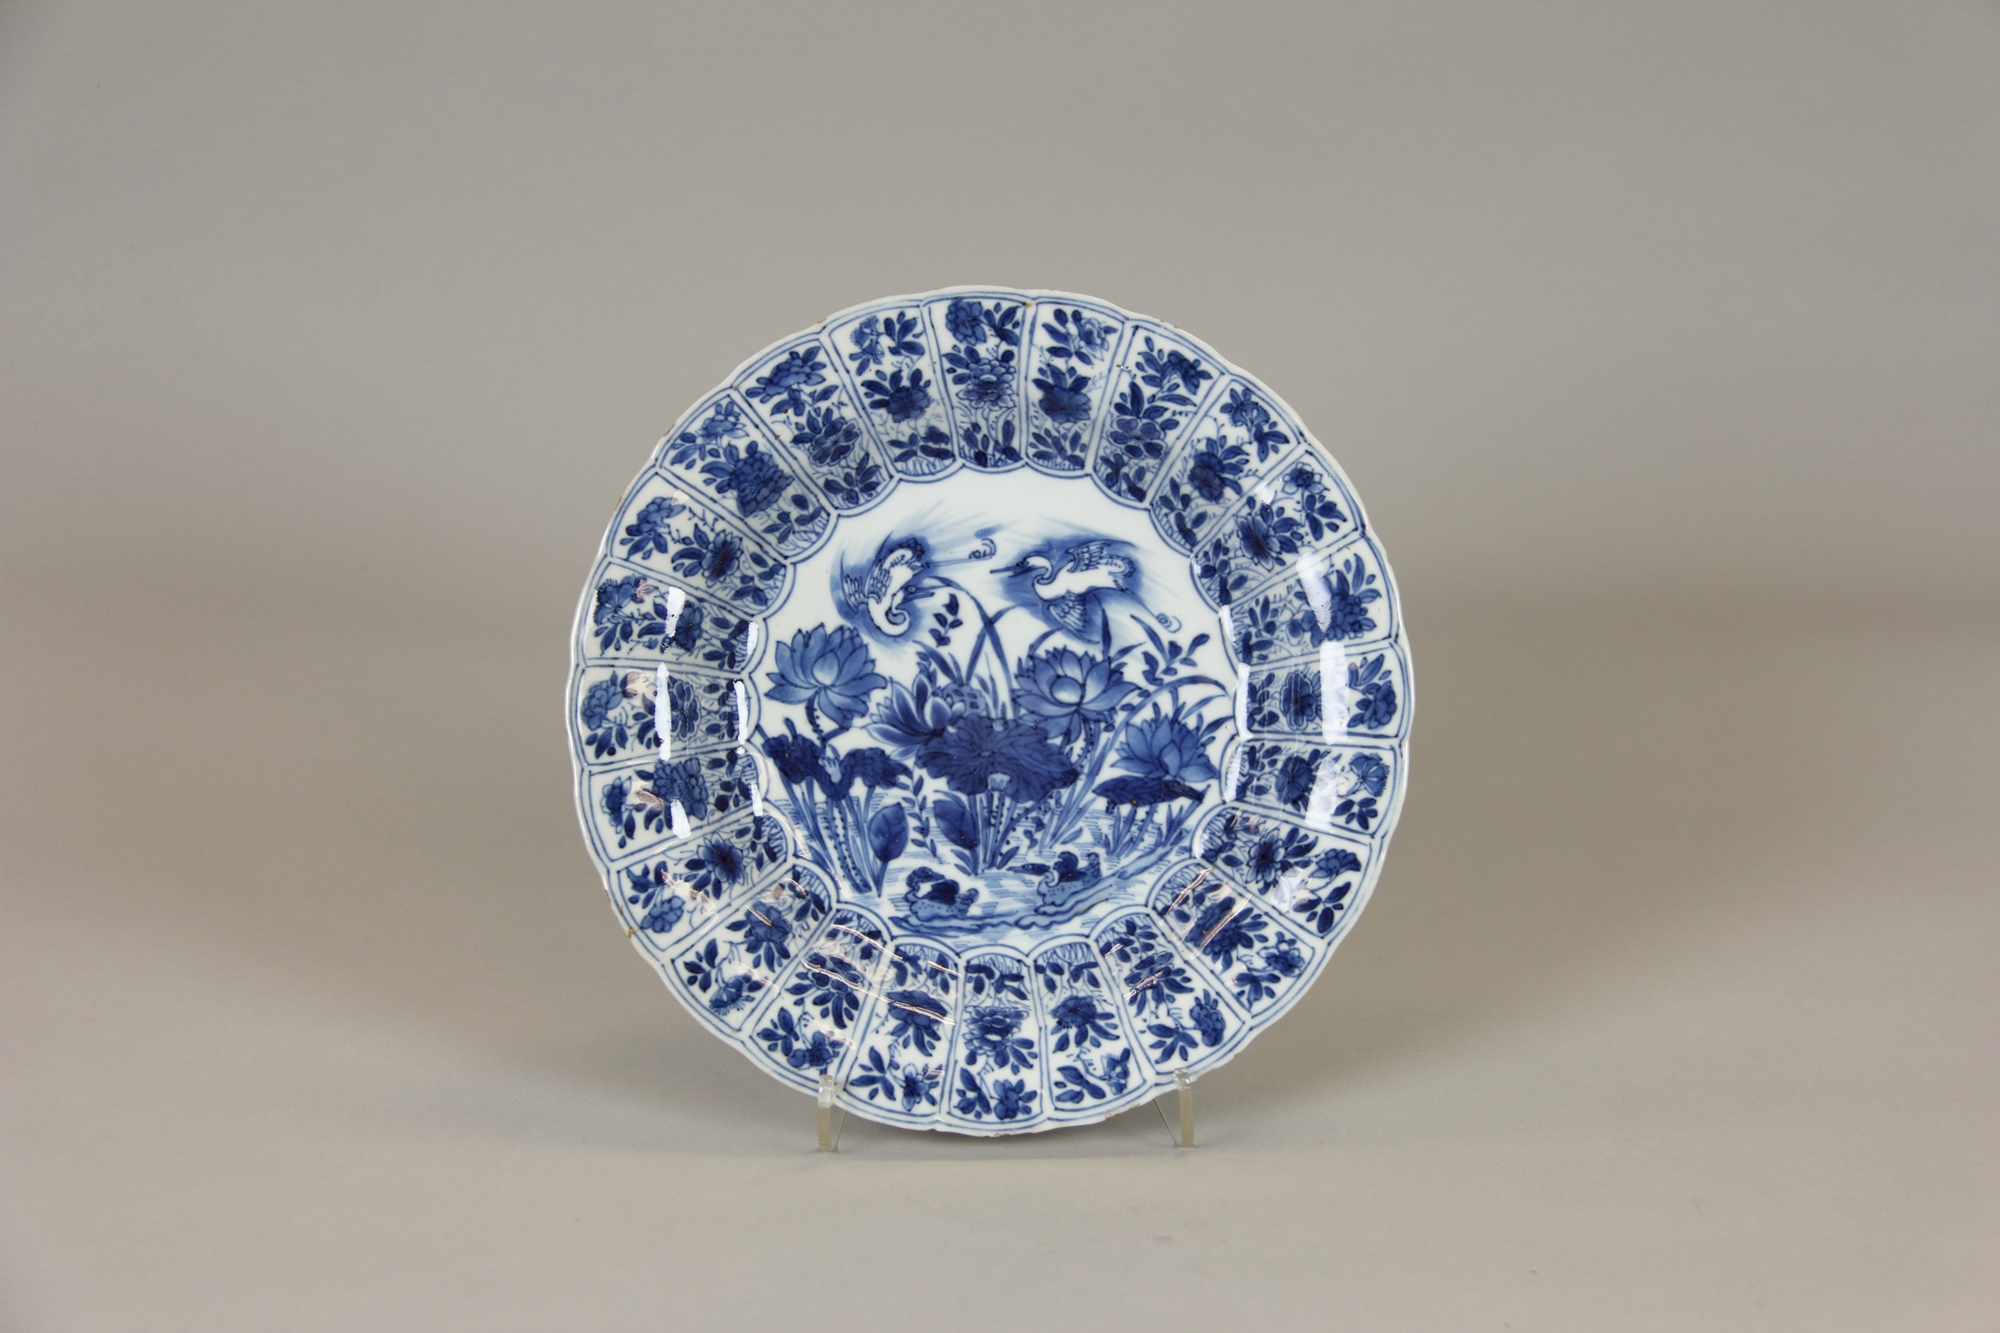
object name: plate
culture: chinese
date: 1667-1733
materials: porcelain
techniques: painting, underglaze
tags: cranes